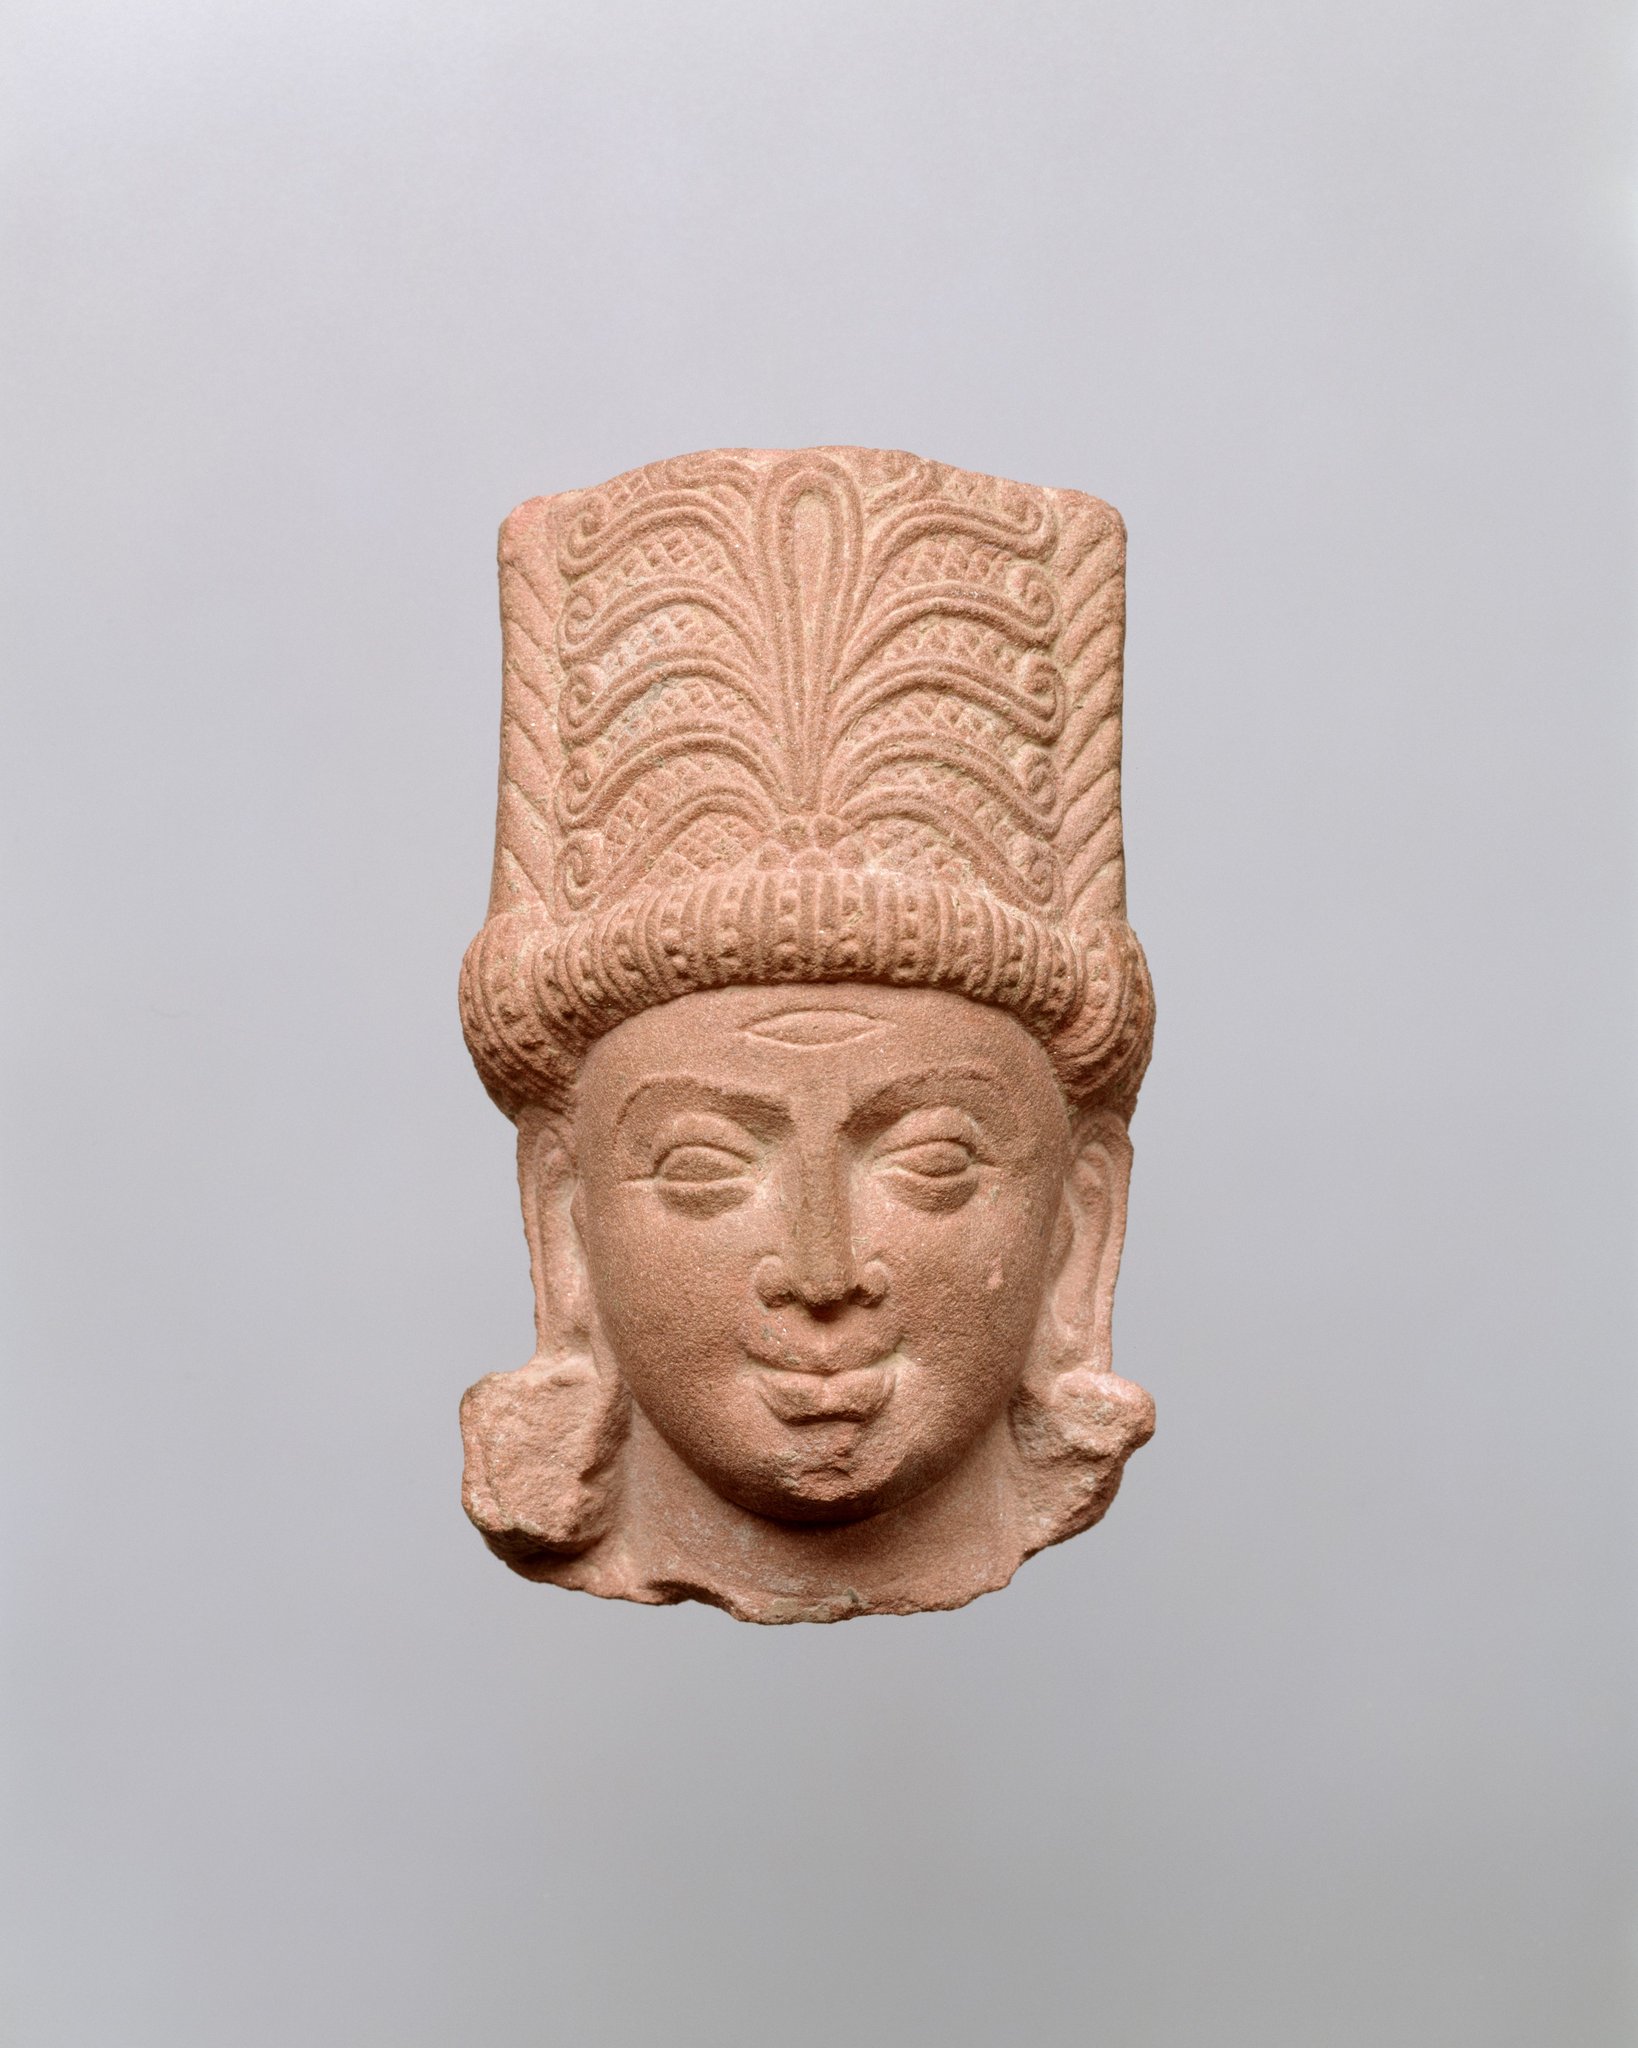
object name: standing indra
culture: indian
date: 101-200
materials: stone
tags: kushan,mathura,heads